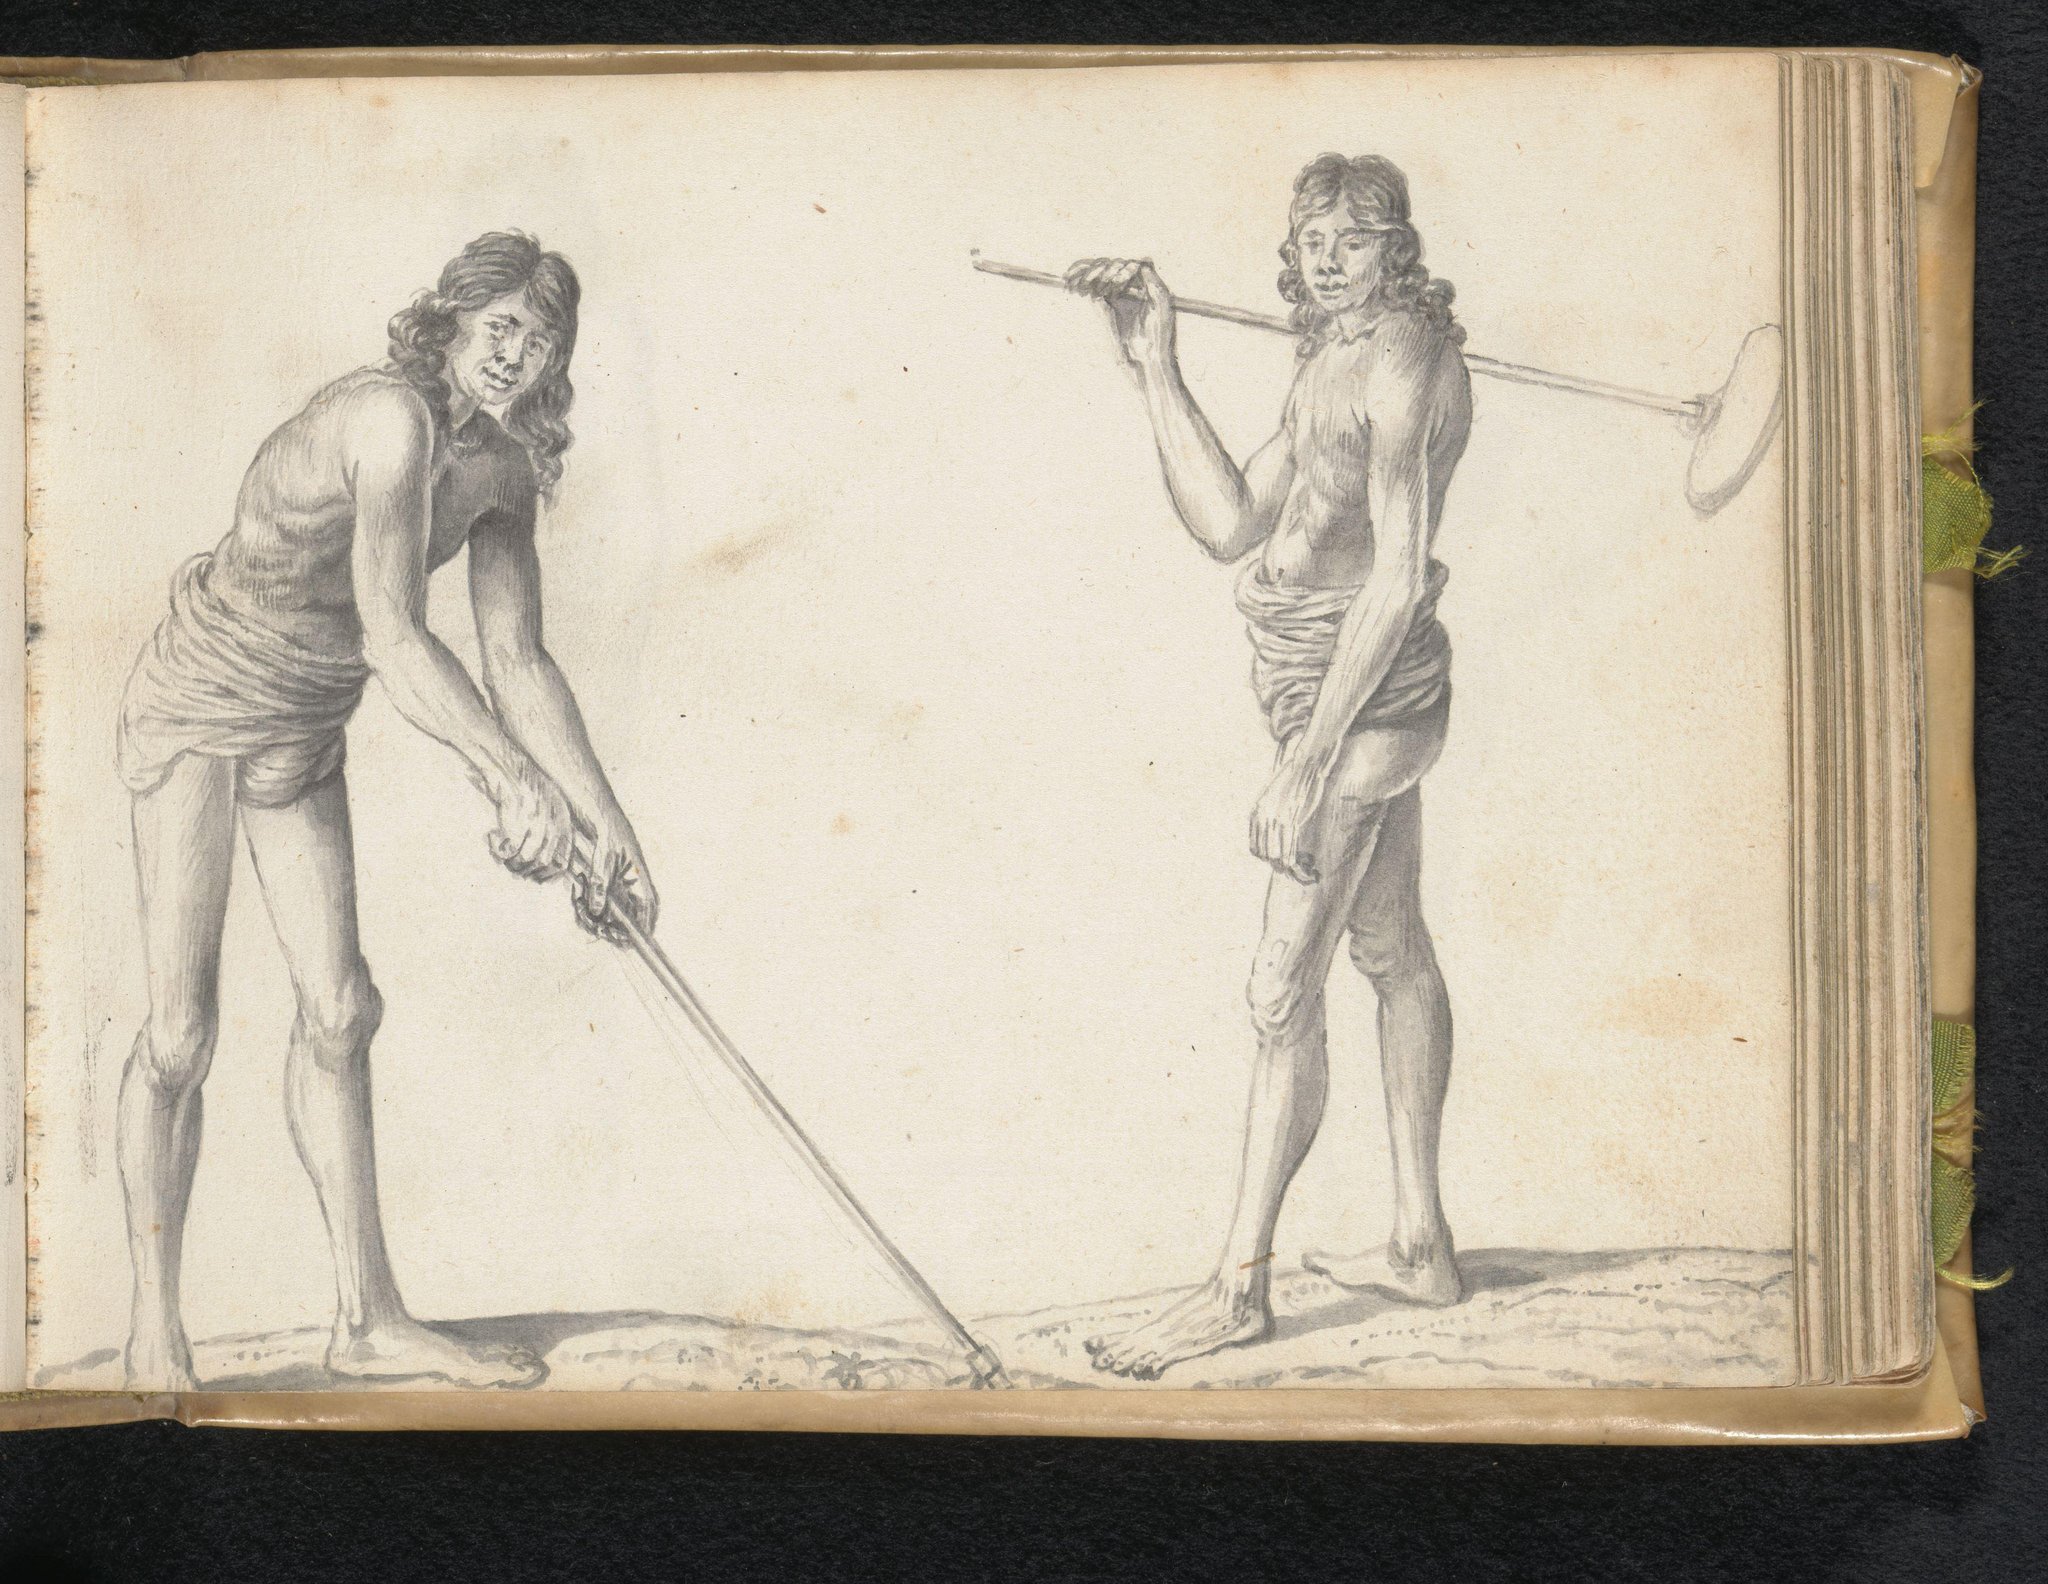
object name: sketchbook leaf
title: Two Sinhalese tillers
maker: esaias boursse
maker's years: 1631-1672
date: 1662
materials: ink, paper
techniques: brush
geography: colombo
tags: agricultural implements: hoe, asiatic races and peoples (with name), underclothes for the lower part of the body (lanket), working class, labourers, sawahs, rice paddies, sri lanka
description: Twee mannen staan buiten in een open veld, elk met een schoffel (udalla) aan een lange stok. Ze dragen beiden alleen een kleine lendendoek (lanket, lunket) die het kruis bedekt en de billen bloot laat. Het lange golvende haar van beide mannen hangt los over de schouders. De man links staat licht voorovergebogen, voeten uit elkaar. Met beide handen houdt hij de stok vast met de schoffel die voor hem op de grond rust. De man rechts – mogelijk dezelfde figuur – staat recht overeind, met zijn linkervoet een stap naar voren, linkerarm langs het lijf. Met de rechterhand houdt hij het uiteinde van de schoffelstok vast die over de rechterschouder ligt, met de schoffel naar achter. Deze man(nen) zijn Singalese landbouwers behorend tot de Goviya-kaste. Er wordt duidelijk geposeerd voor de tekenaar met het werktuig gebruikt om de dijkjes te maken in een rijstveld. Blad 28 uit een schetsboek met 117 bladen.